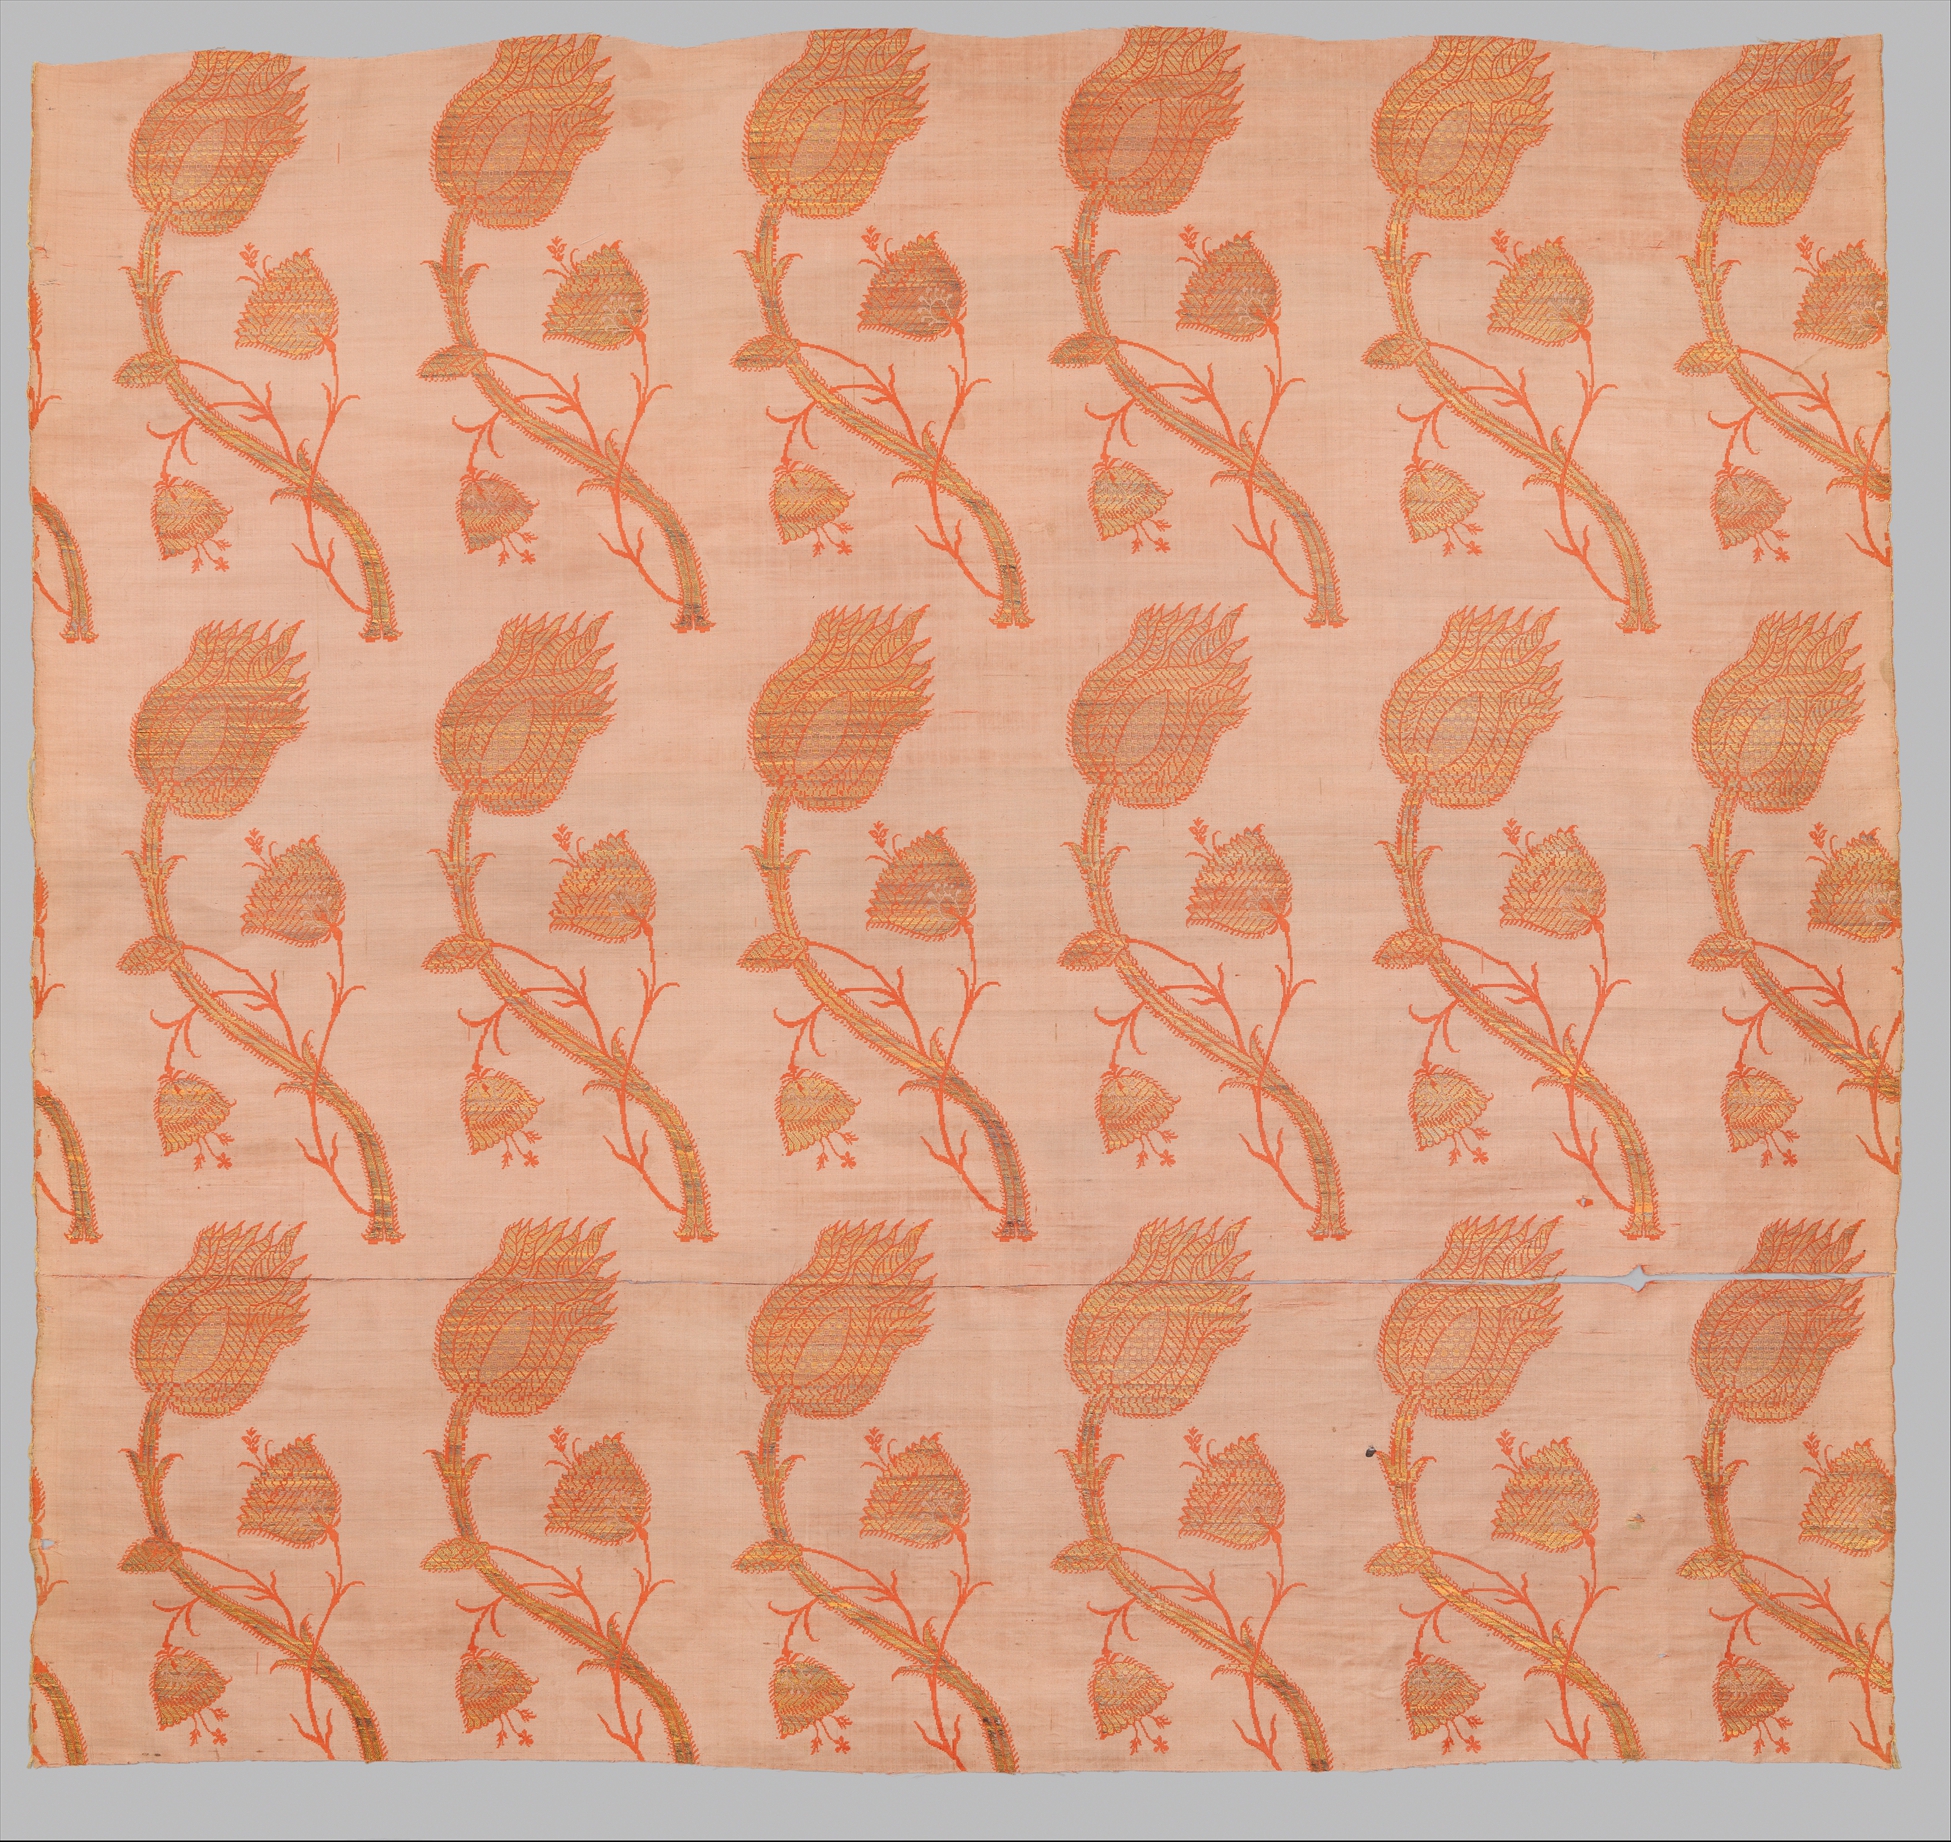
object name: textile fragment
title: Textile Fragment with a Repeating Pattern of Interlocked Tulips and Poppies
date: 1628-1658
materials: metal thread, silk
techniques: brocade, weave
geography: india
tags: poppies,tulips